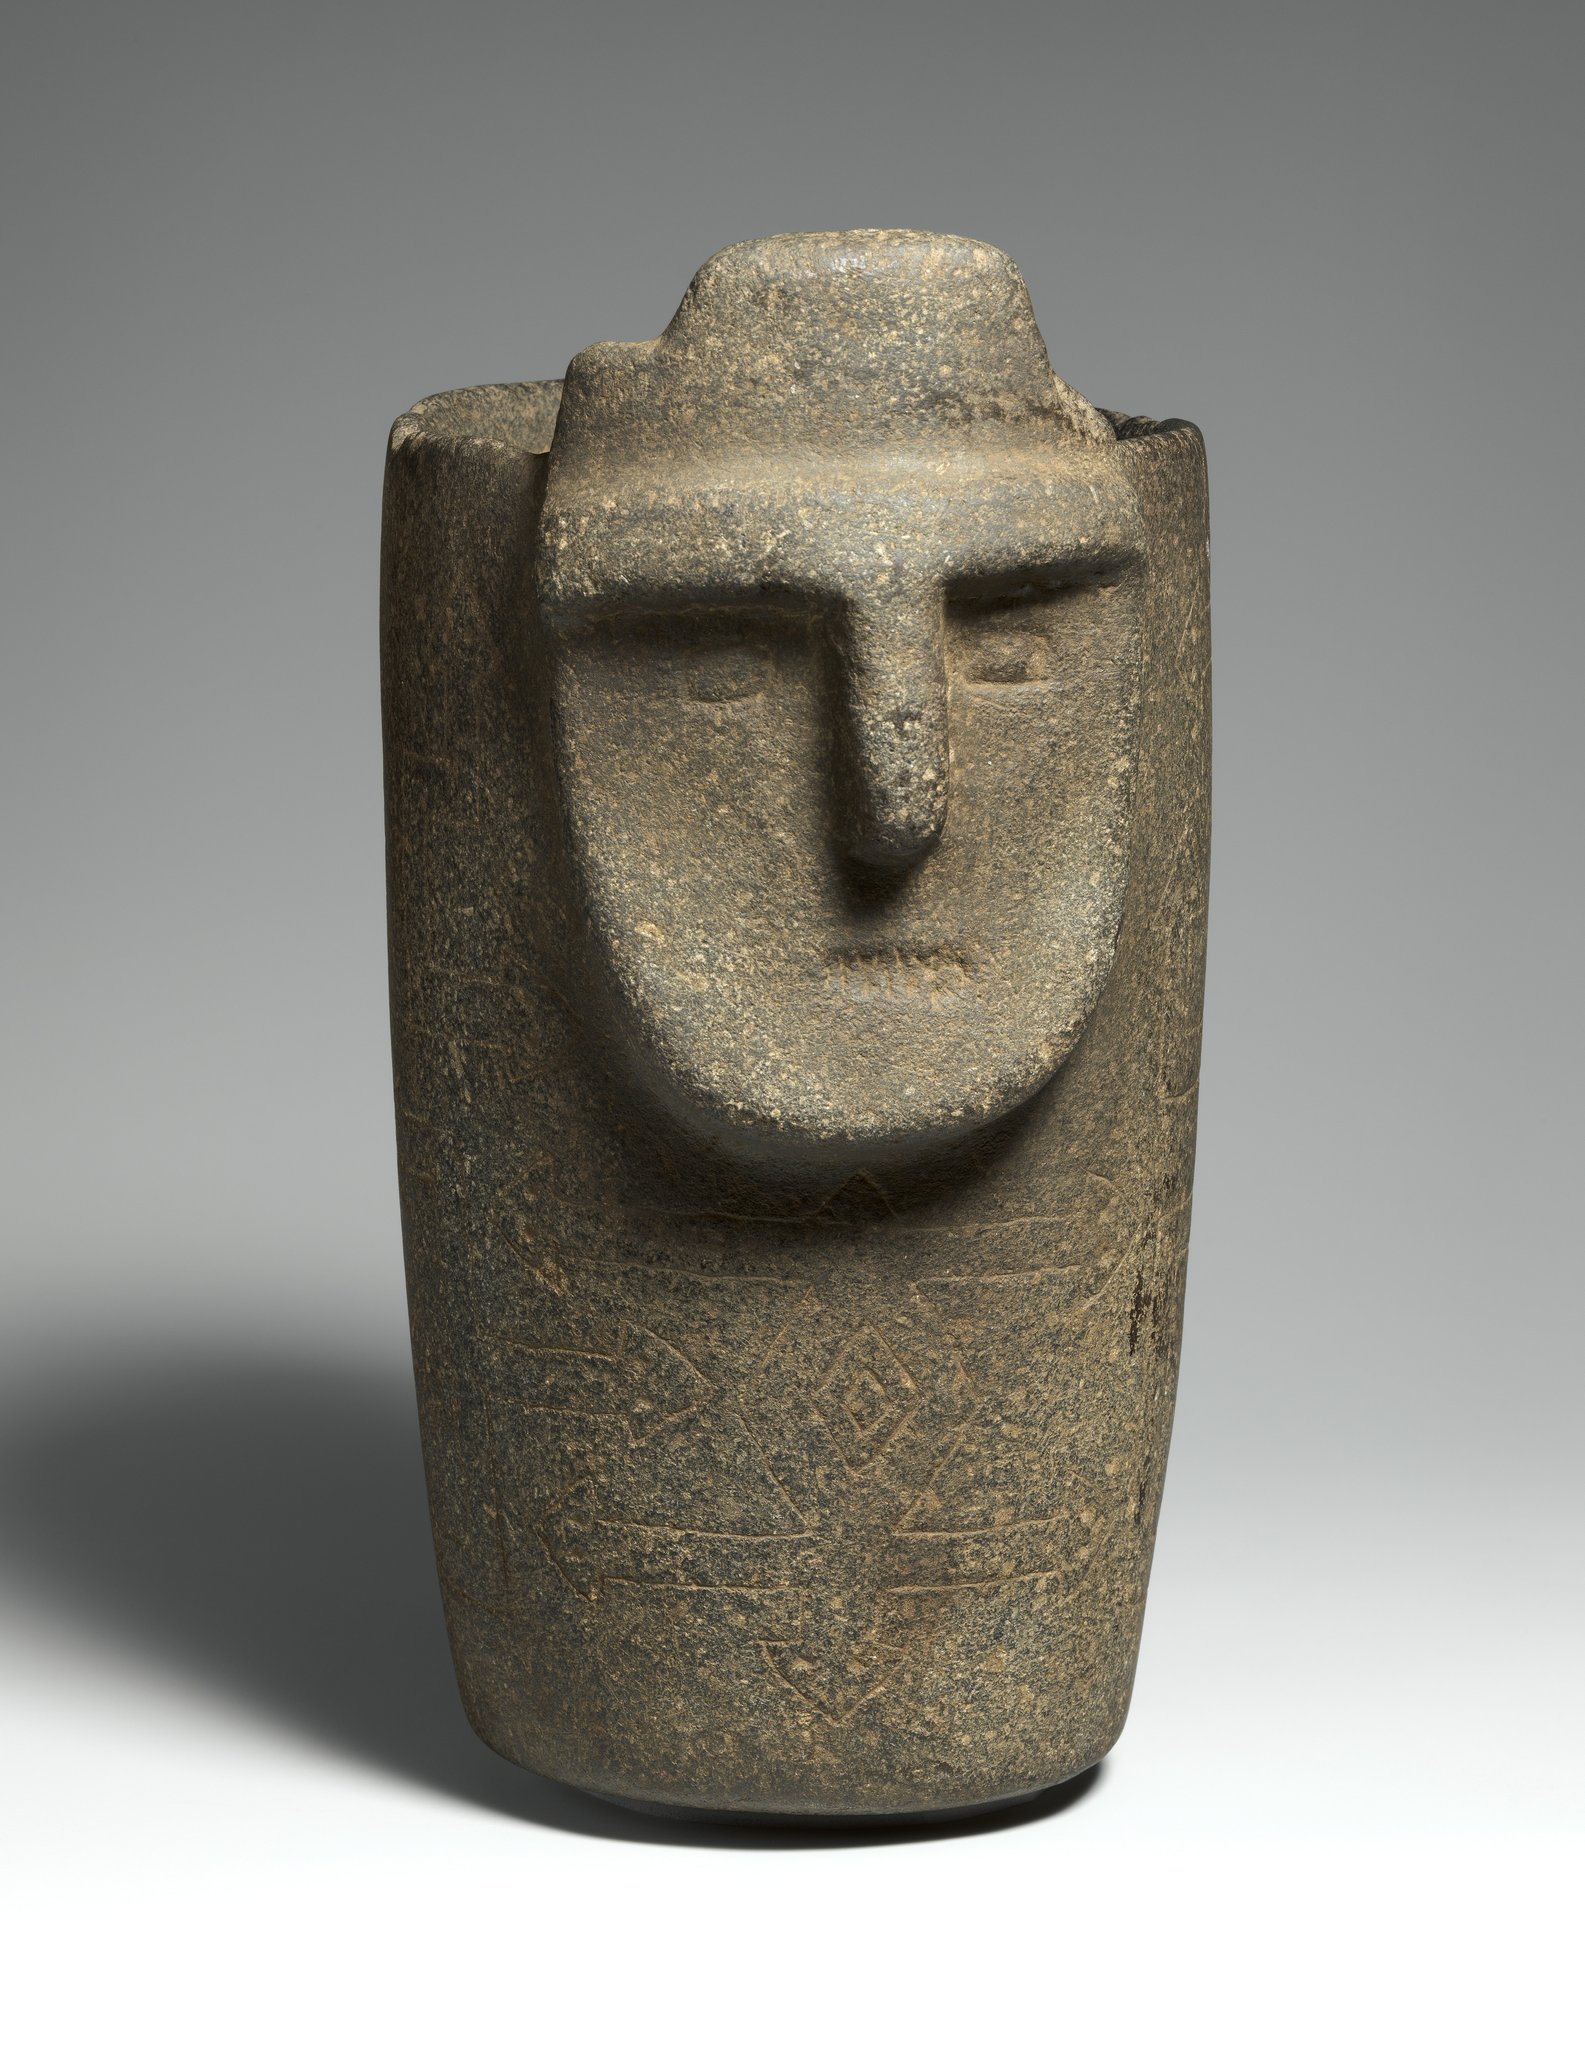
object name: vessel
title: Beaker with face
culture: condorhuasi-alamito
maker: condorhuasi-alamito artist(s)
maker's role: artist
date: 500 BCE-500 CE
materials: stone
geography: argentina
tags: faces